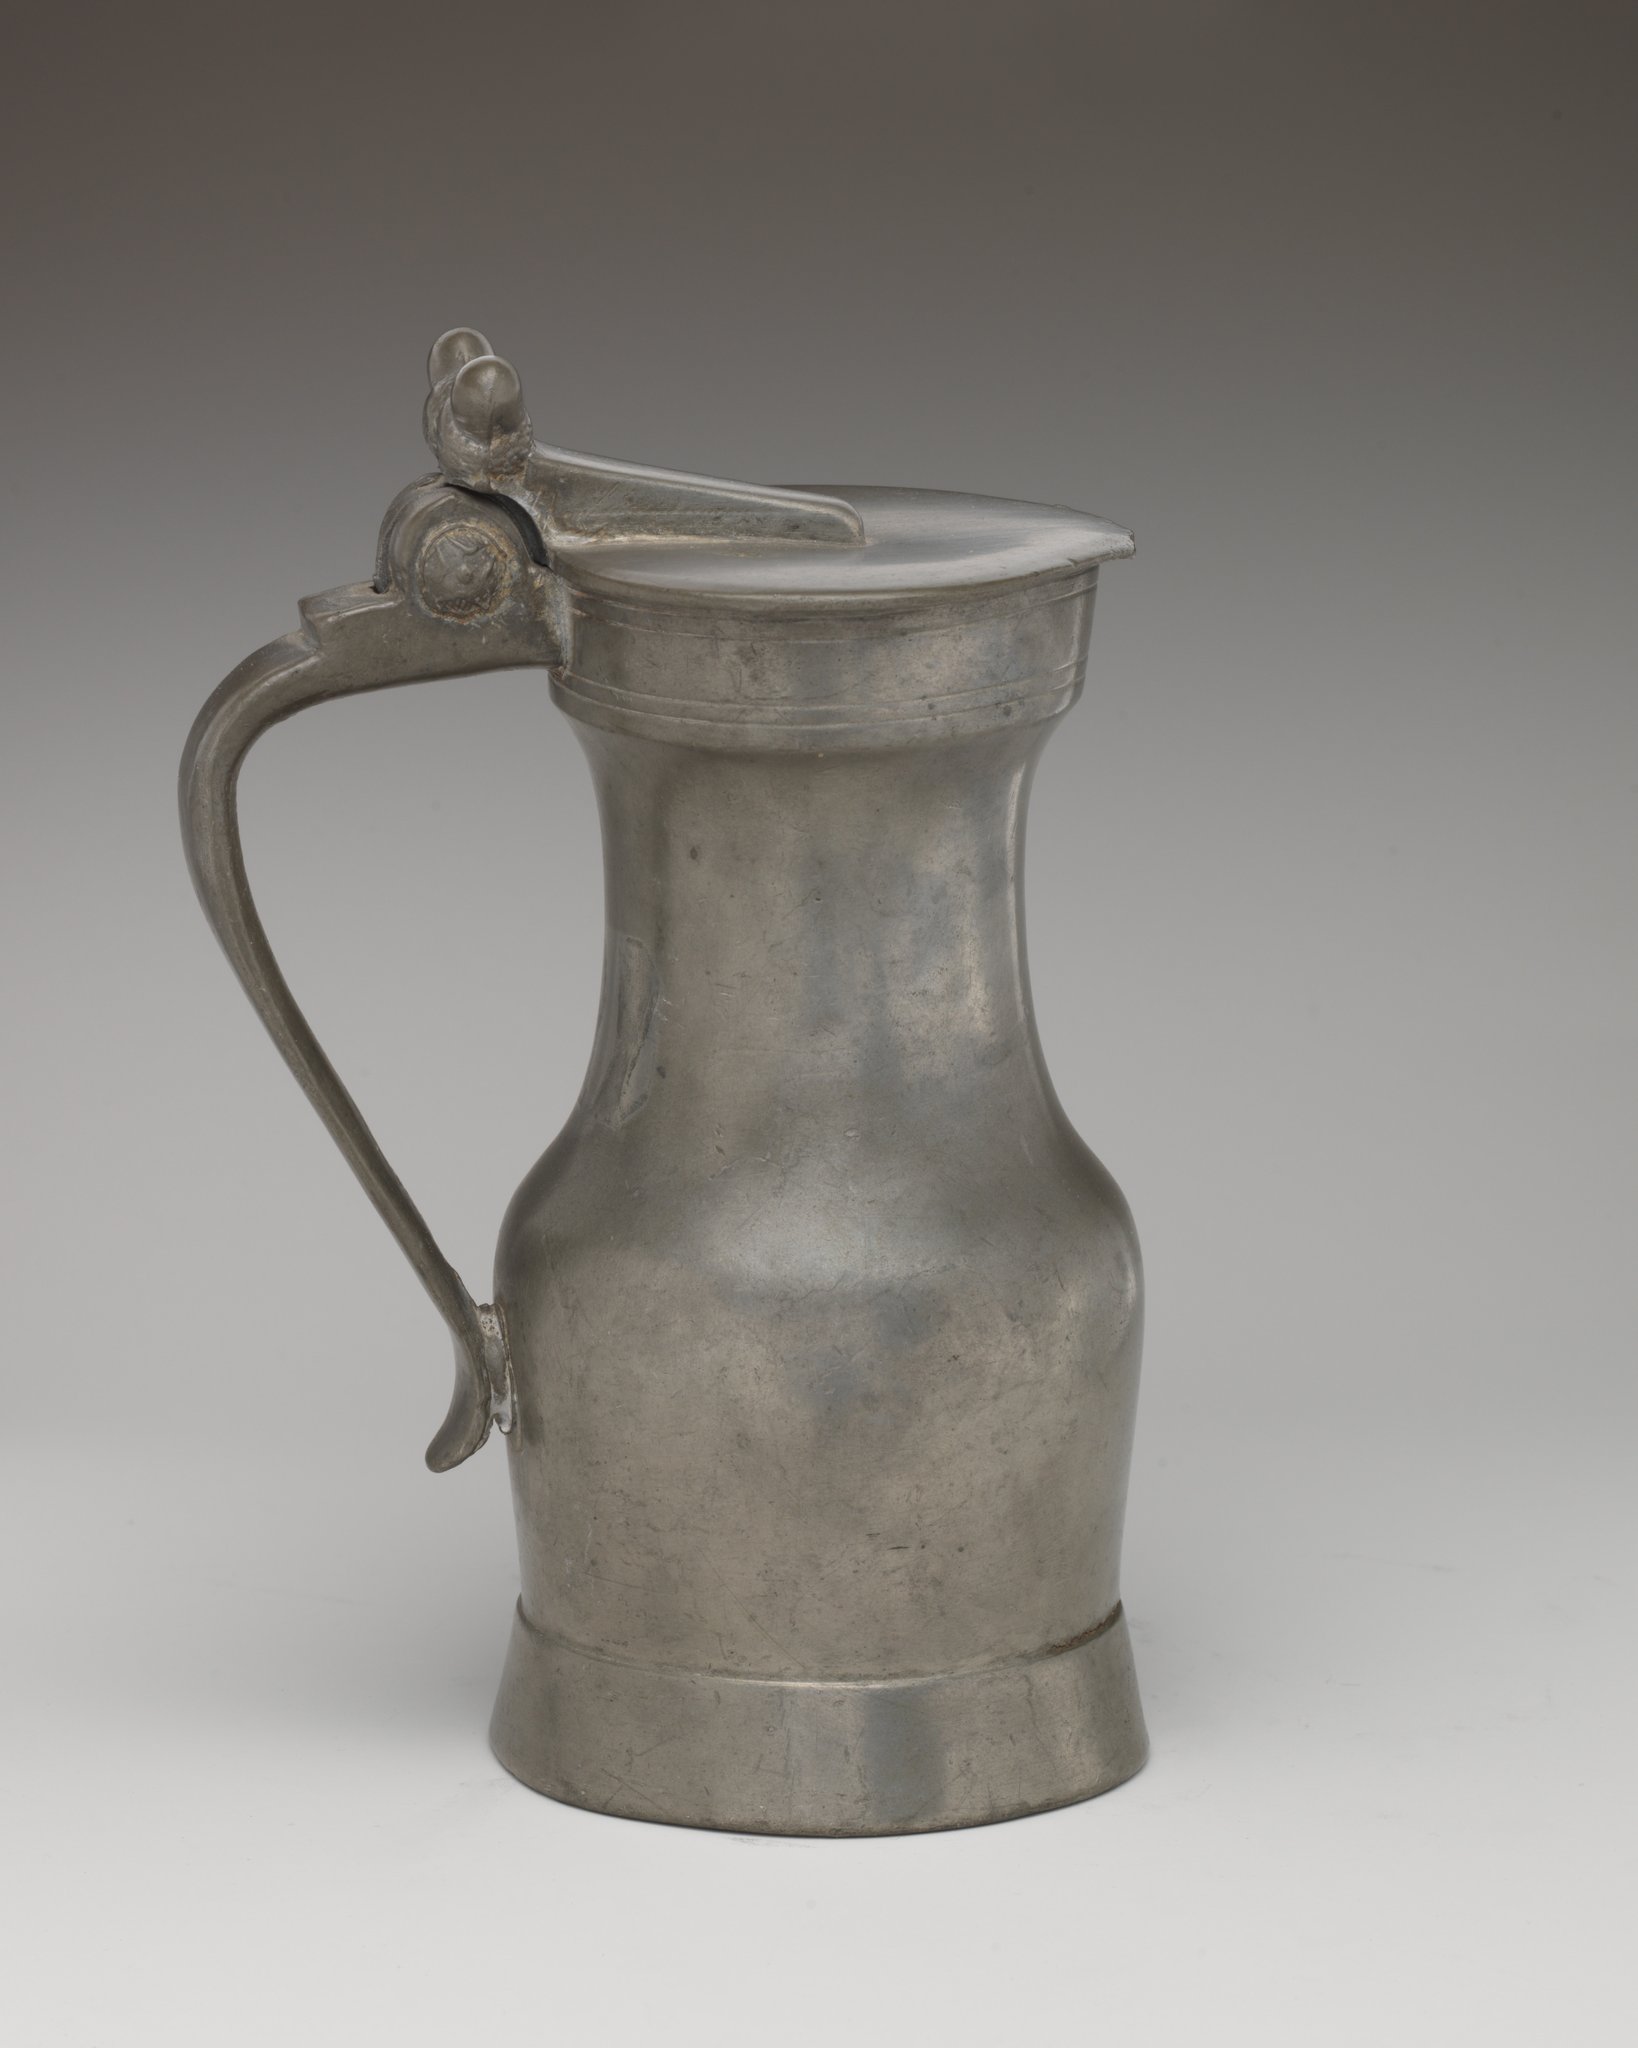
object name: measure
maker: c. b. s., rouen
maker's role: maker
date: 1701-1800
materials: pewter